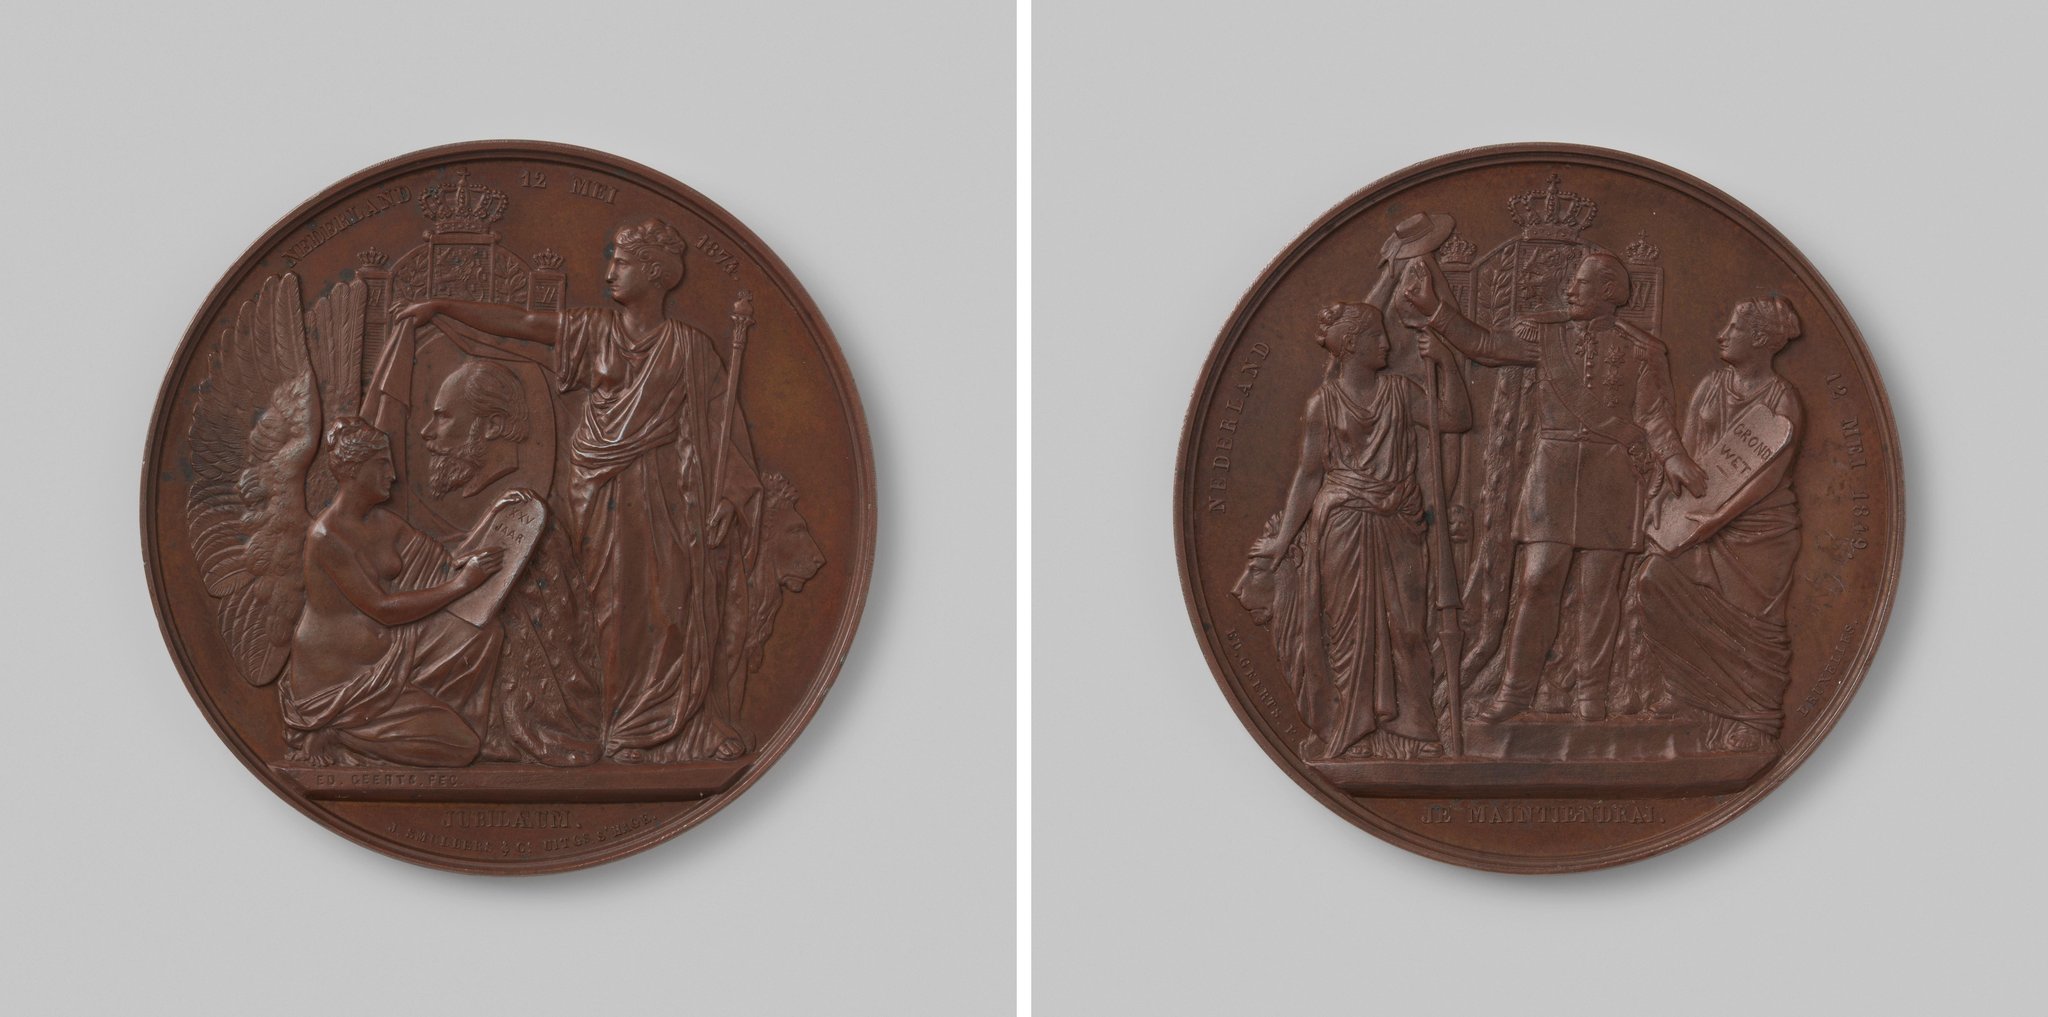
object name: history medal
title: Vijfentwintigjarig regeringsjubileum van Willem III, koning der Nederlanden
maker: edouard louis geerts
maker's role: medailleur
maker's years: 1846-1889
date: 1874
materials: bronze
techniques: striking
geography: the hague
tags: willem iii (koning der nederlanden), low countries